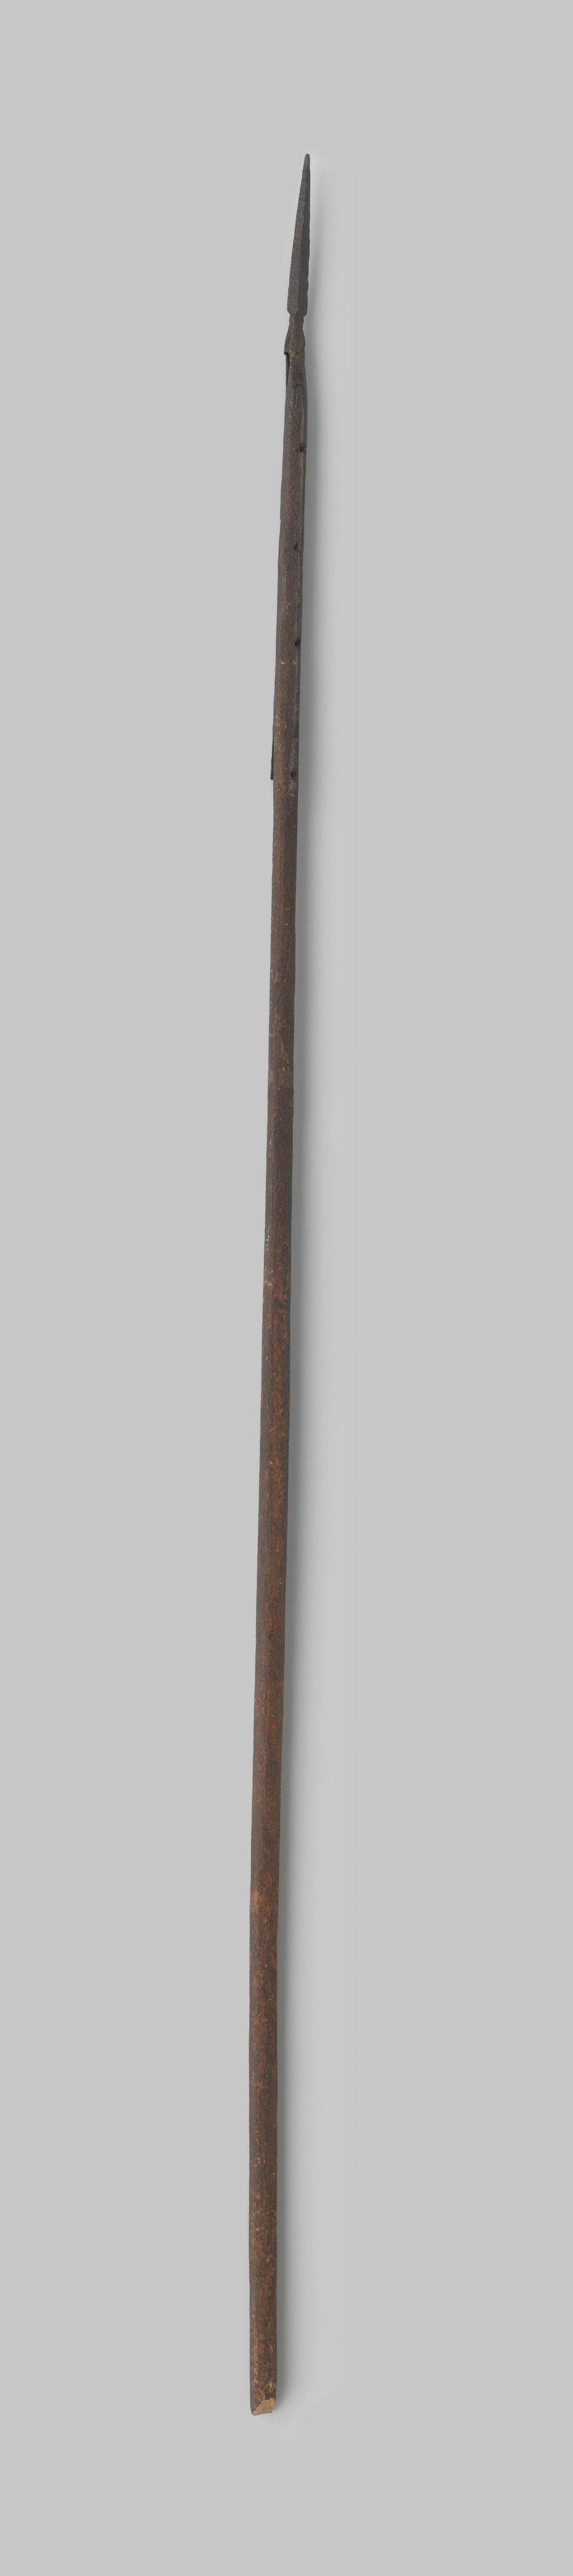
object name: pike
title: Piek met veren en houten steel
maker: Anonymous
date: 1590-1596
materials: iron, wood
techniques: cutting, forging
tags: willem barendsz., amsterdam, jacob van heemskerck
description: Weapons. Weapons were an essential part of any distant voyage. On Nova Zembla they were used to keep the polar bears at bay.